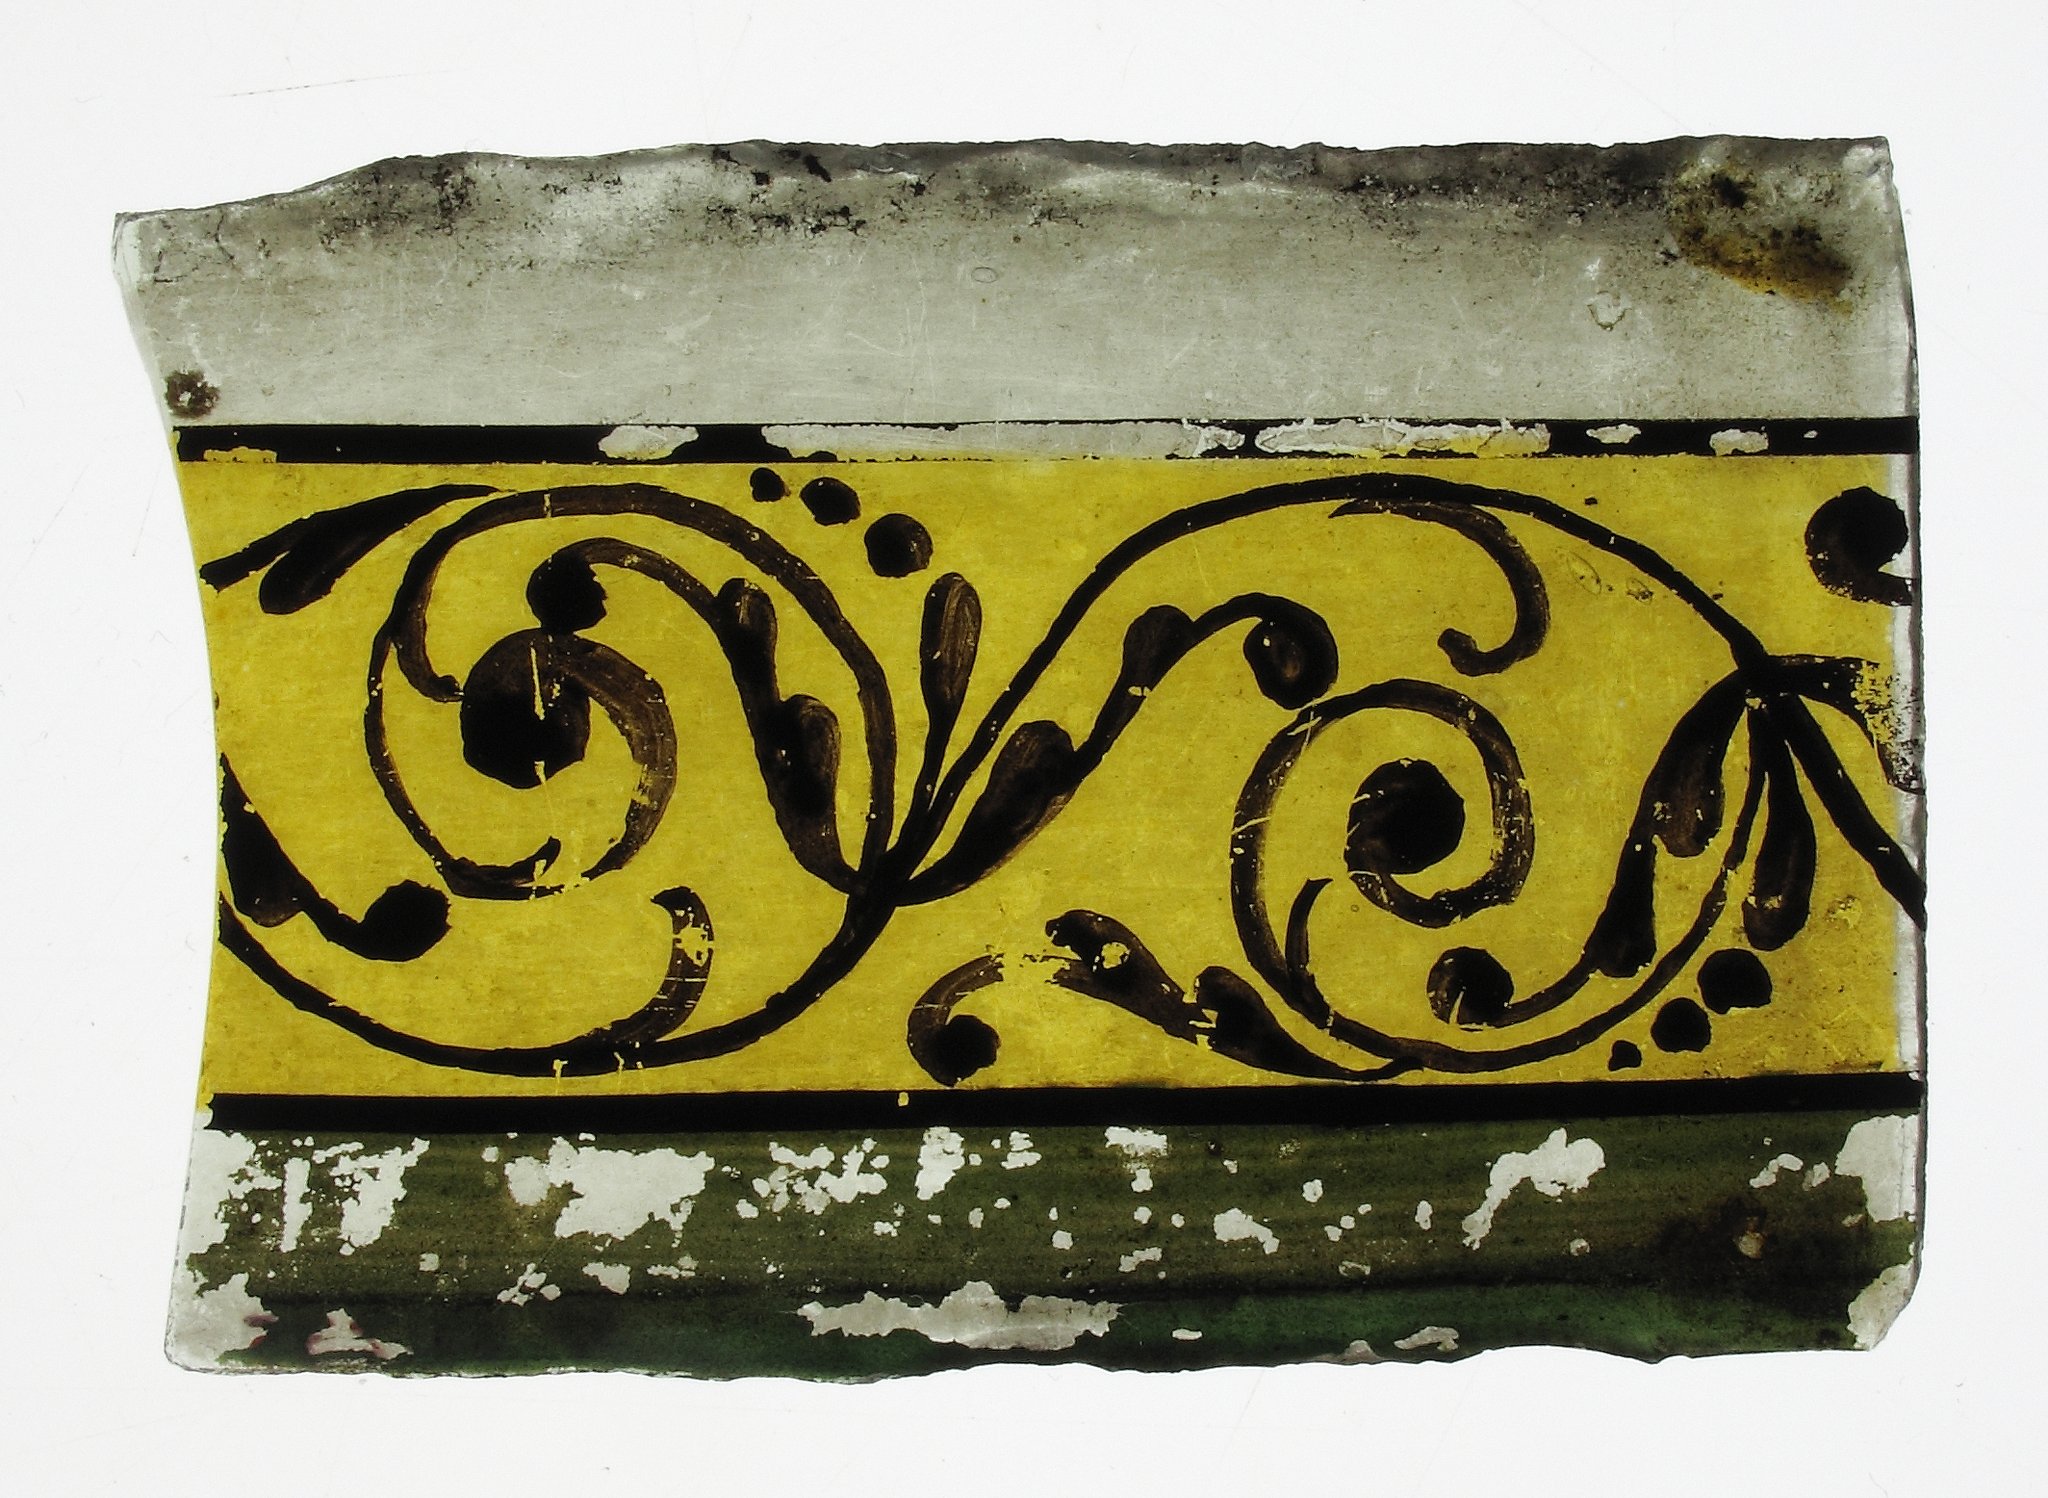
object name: fragment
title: Glass Fragment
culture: european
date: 1801-1900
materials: glass, paint, pigment